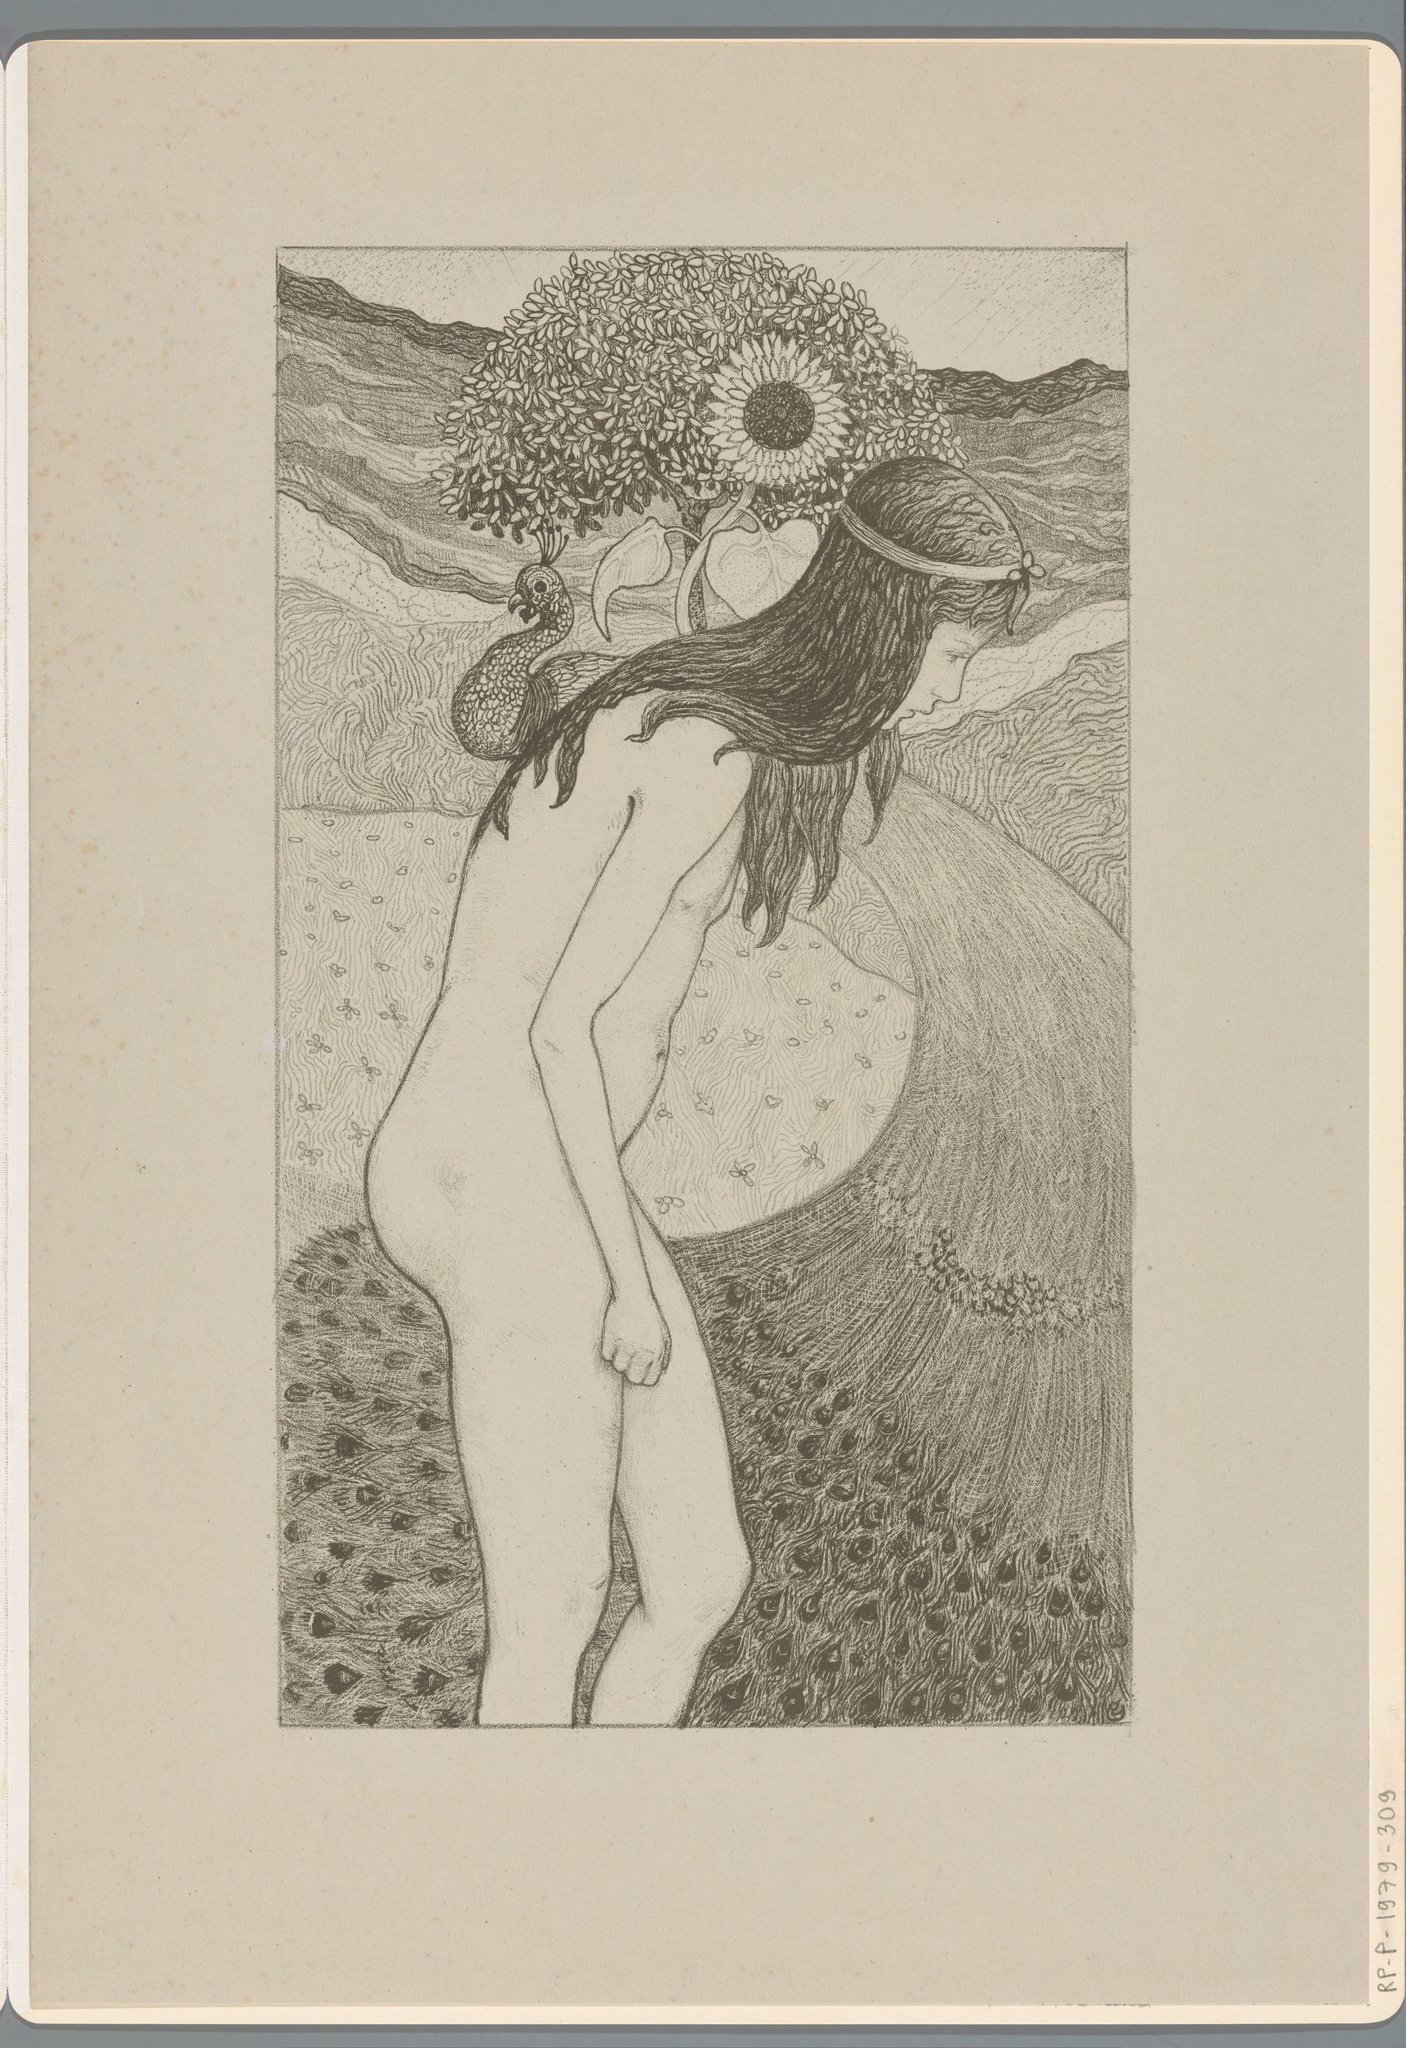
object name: print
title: Kind met pauw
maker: richard nicolaüs roland holst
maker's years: 1868-1938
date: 1892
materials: paper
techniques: lithograph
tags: low hill country, trees, flowers: sunflower, (showing oneself) undressed, quasi-nude, child, ornamental birds: peacock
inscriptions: collector's mark: Lugt 2228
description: Een naakt, staand kind in een heuvellandschap. Op de schouder van het kind zit een pauw. Achter het kind en de pauw groeien een zonnebloem en een boom.